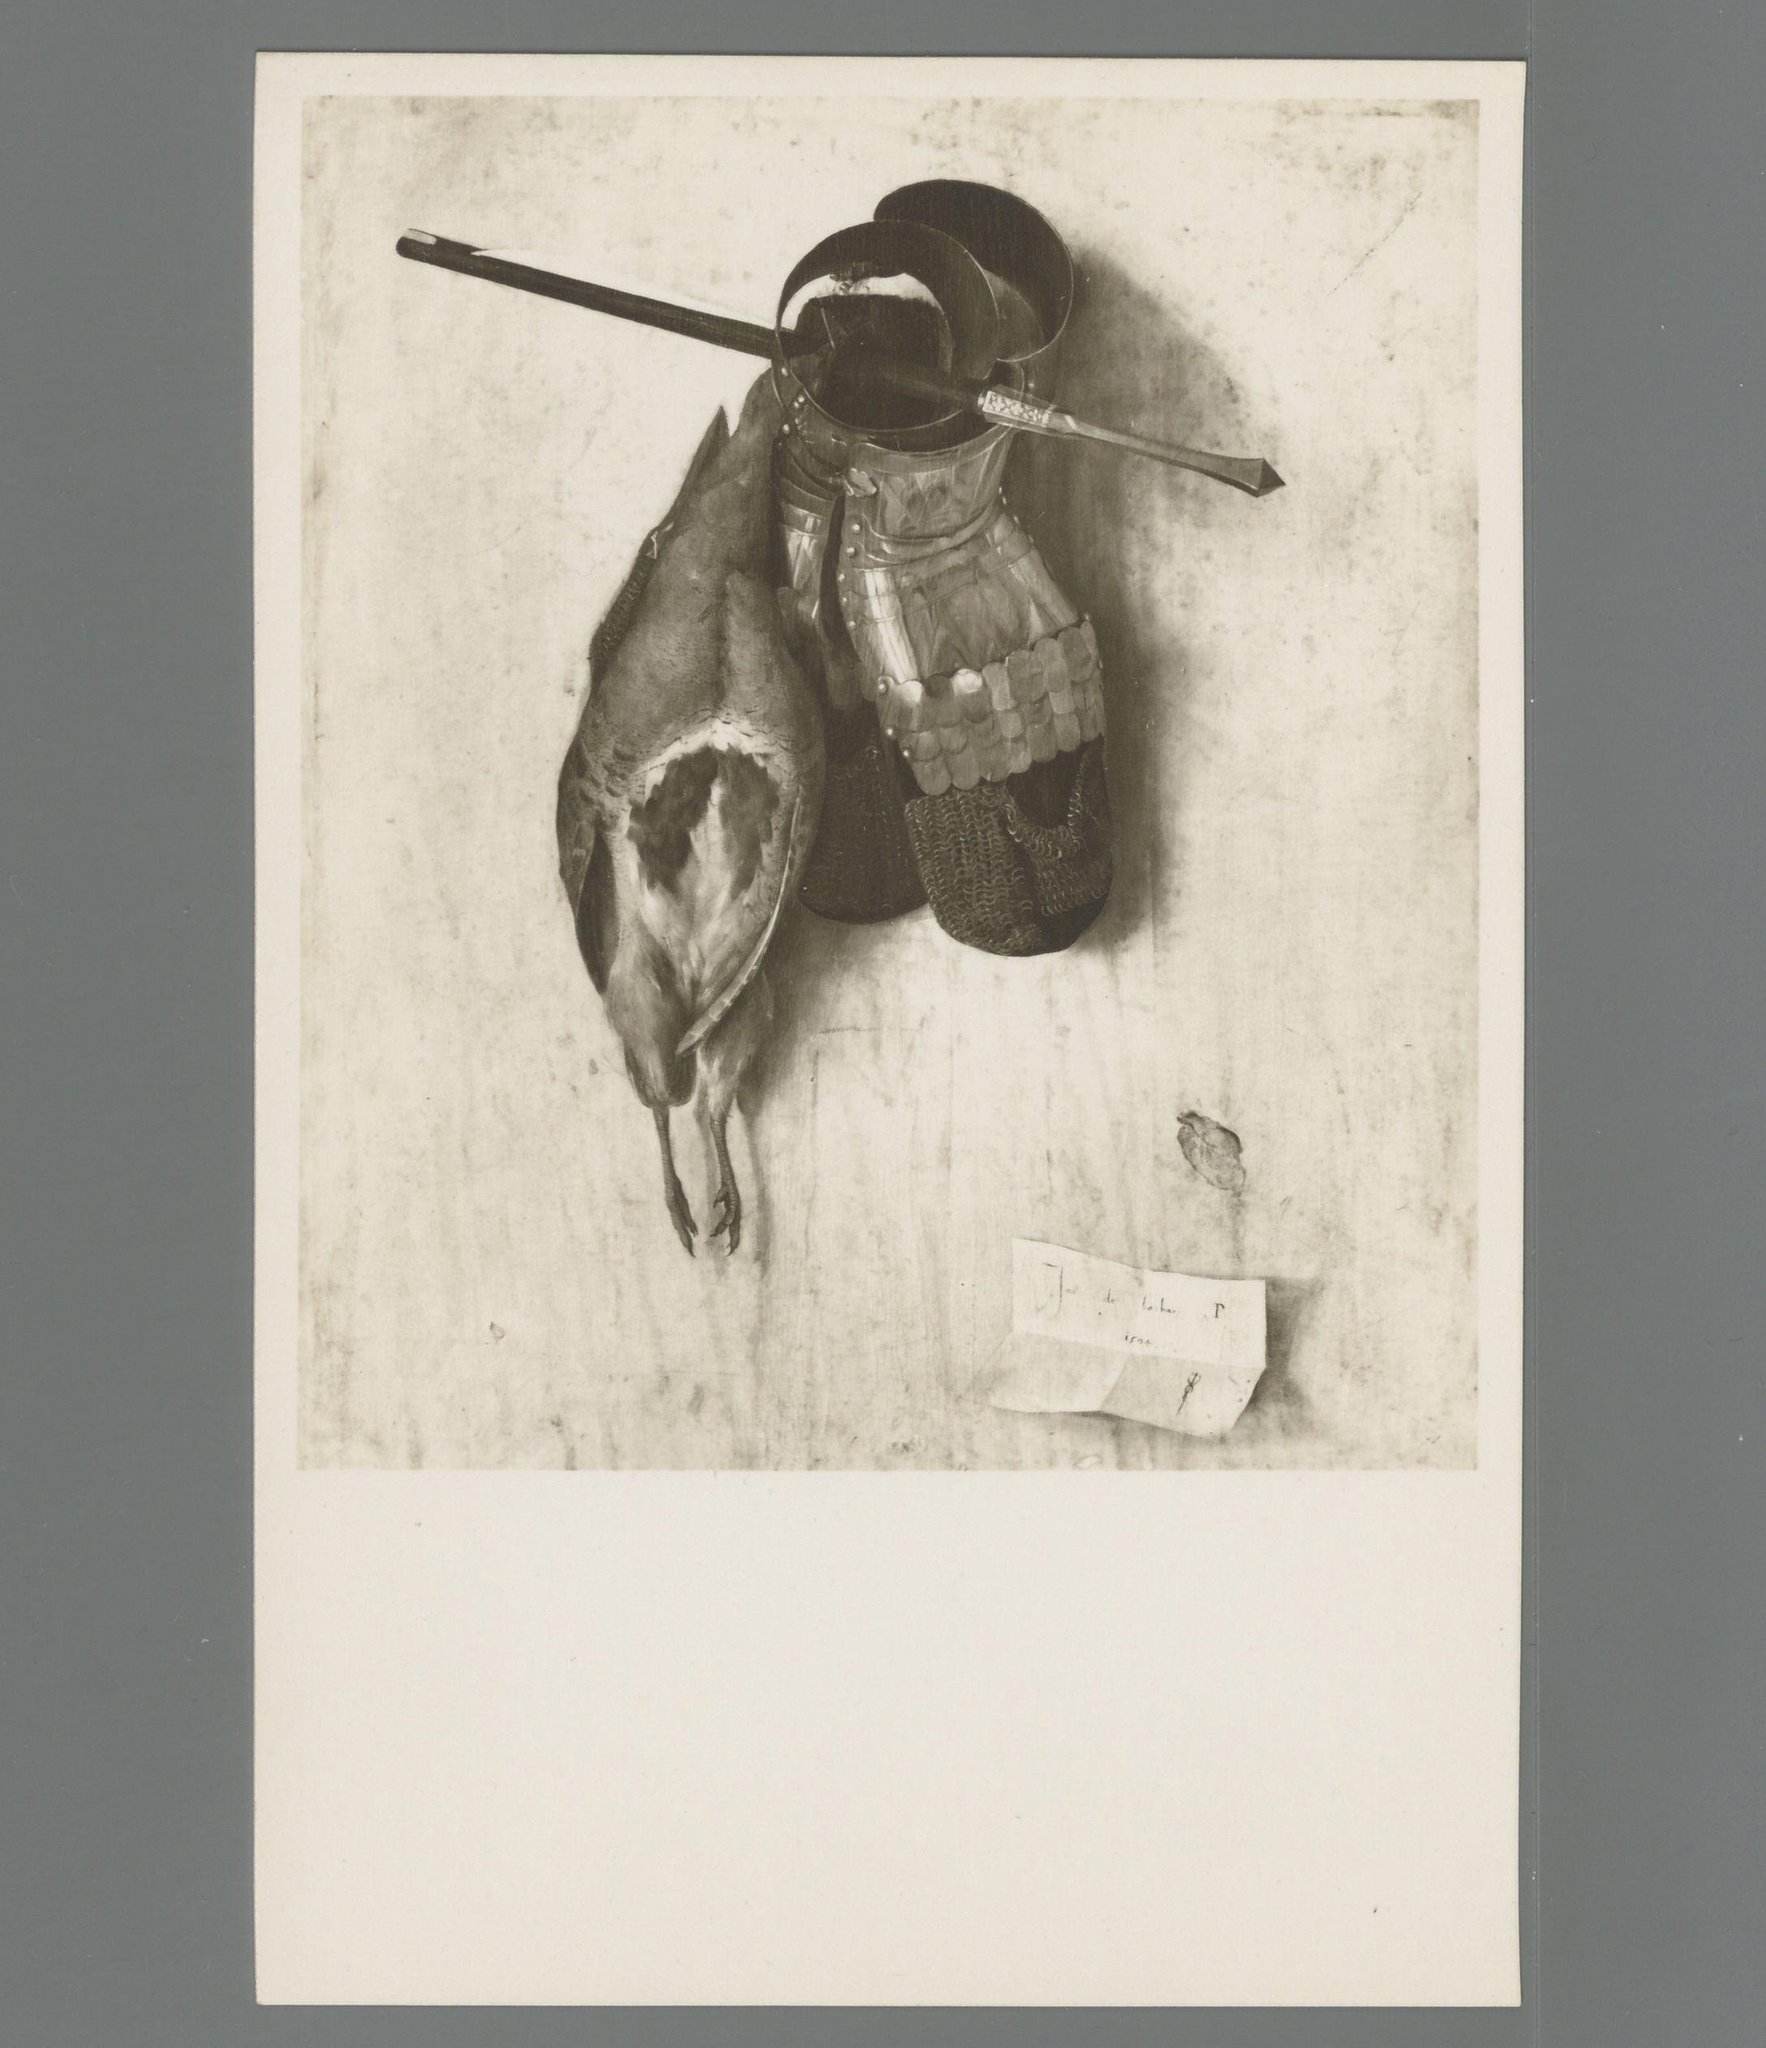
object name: reproduction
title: Stilleben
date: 1905-1930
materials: photographic support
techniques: photography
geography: munich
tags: walker and runner birds: partridge, weapons, hunting trophies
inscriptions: mark: ‘SS’